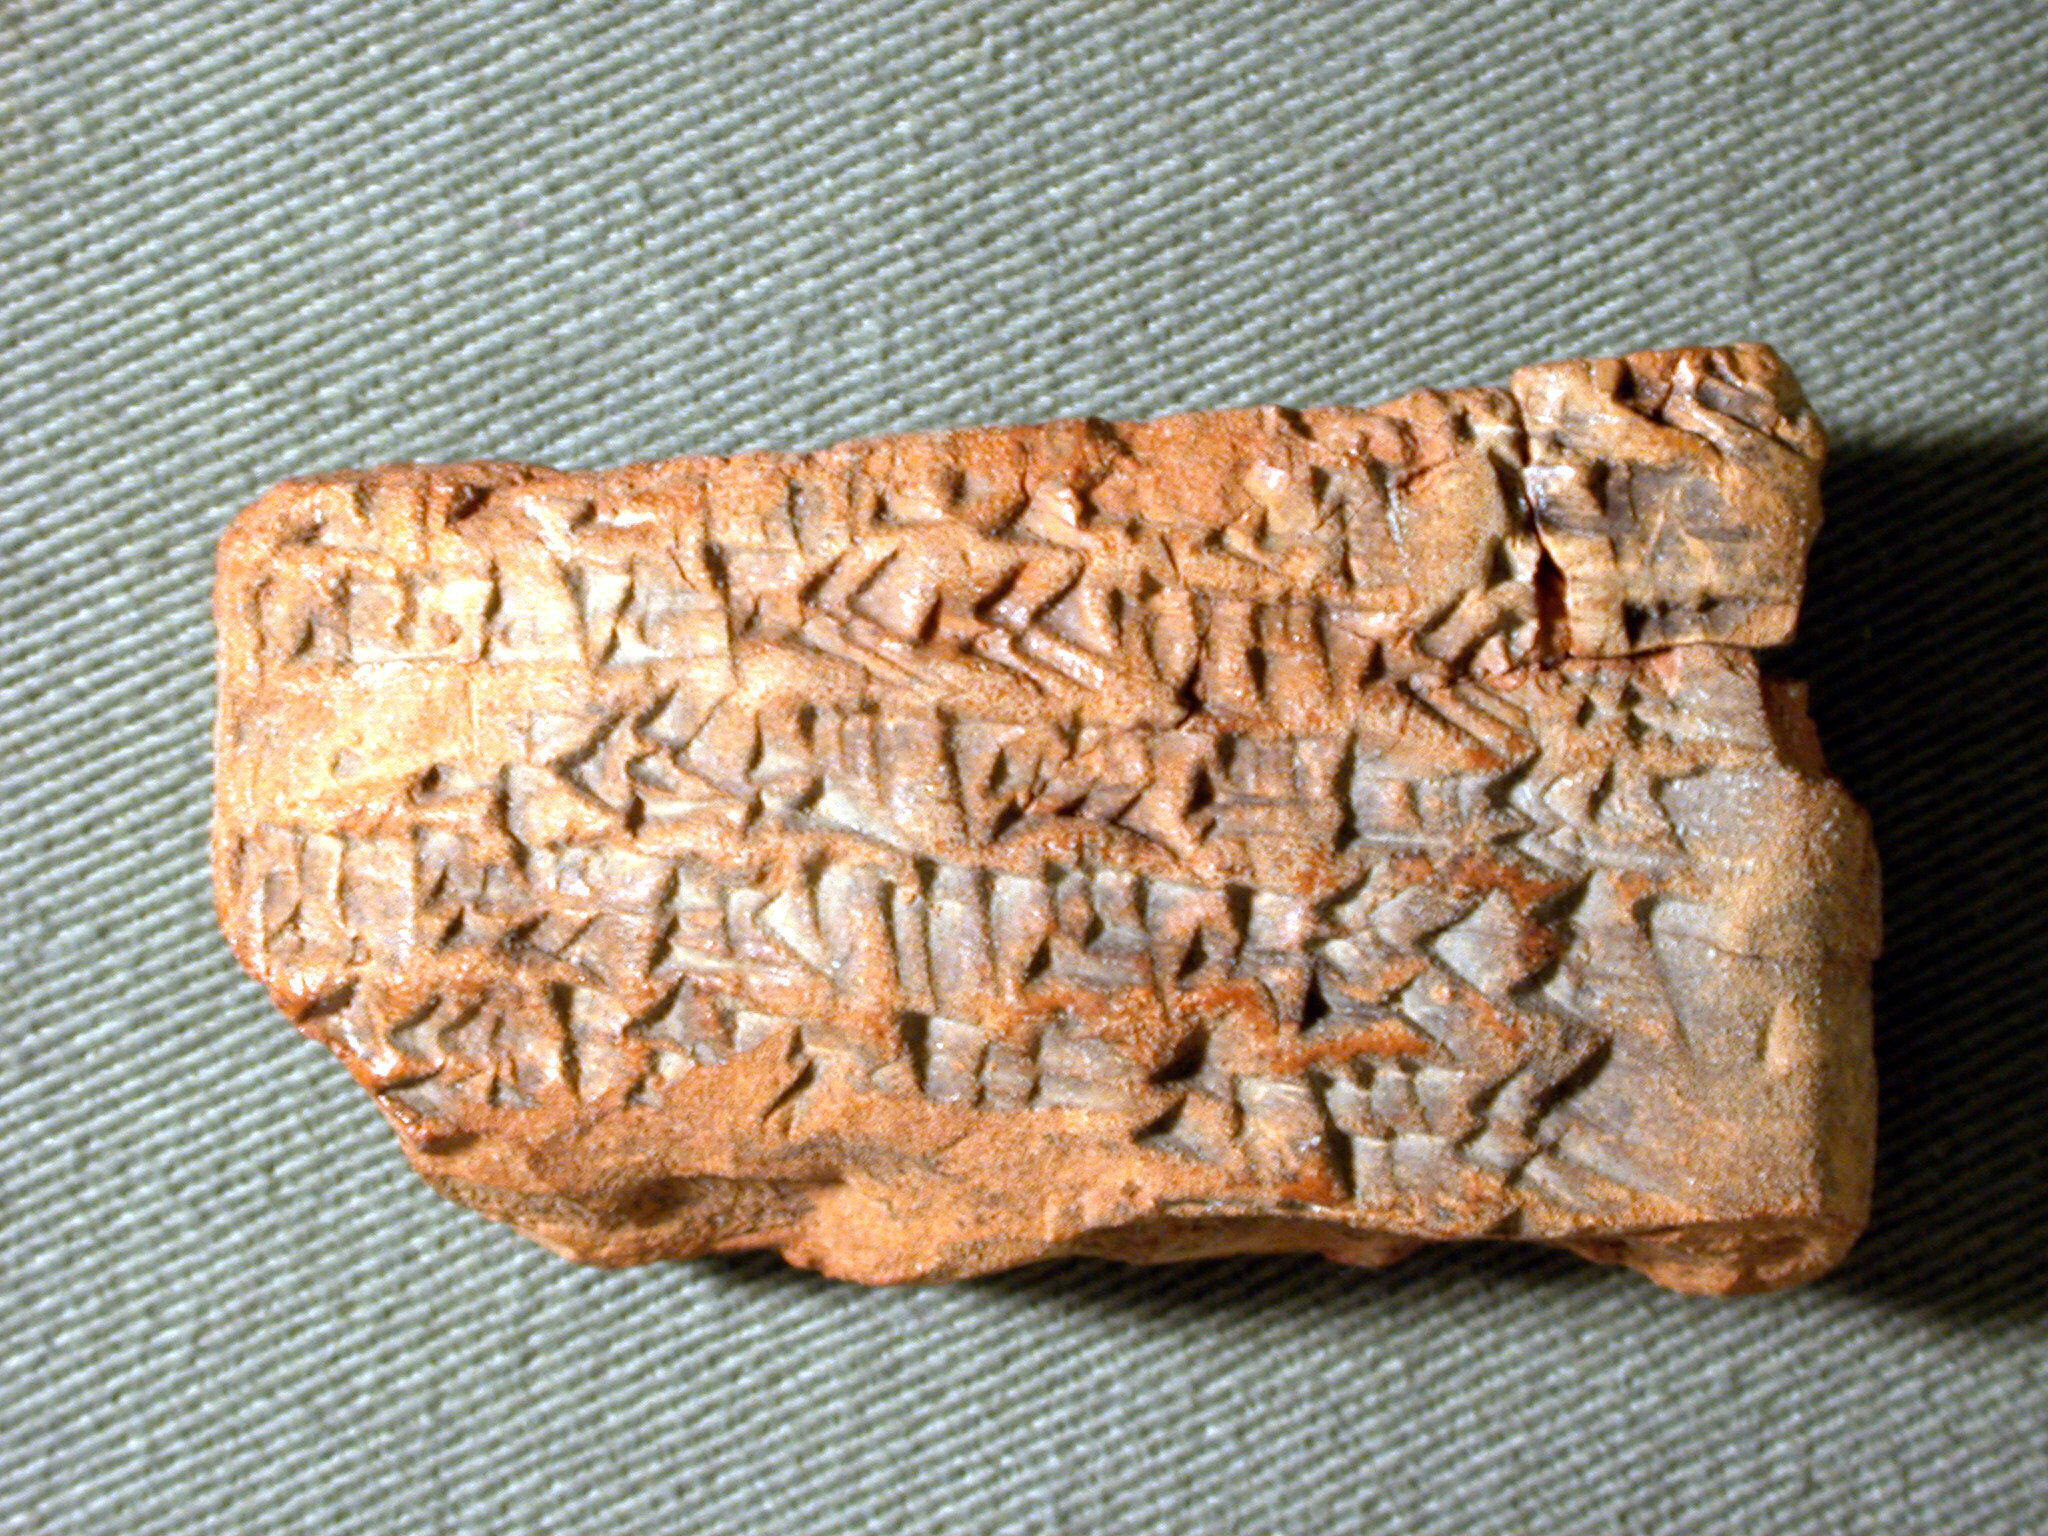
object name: cuneiform tablet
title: Cuneiform tablet: fragment of a contract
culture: achaemenid or babylonian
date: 700-301 BCE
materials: clay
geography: mesopotamia